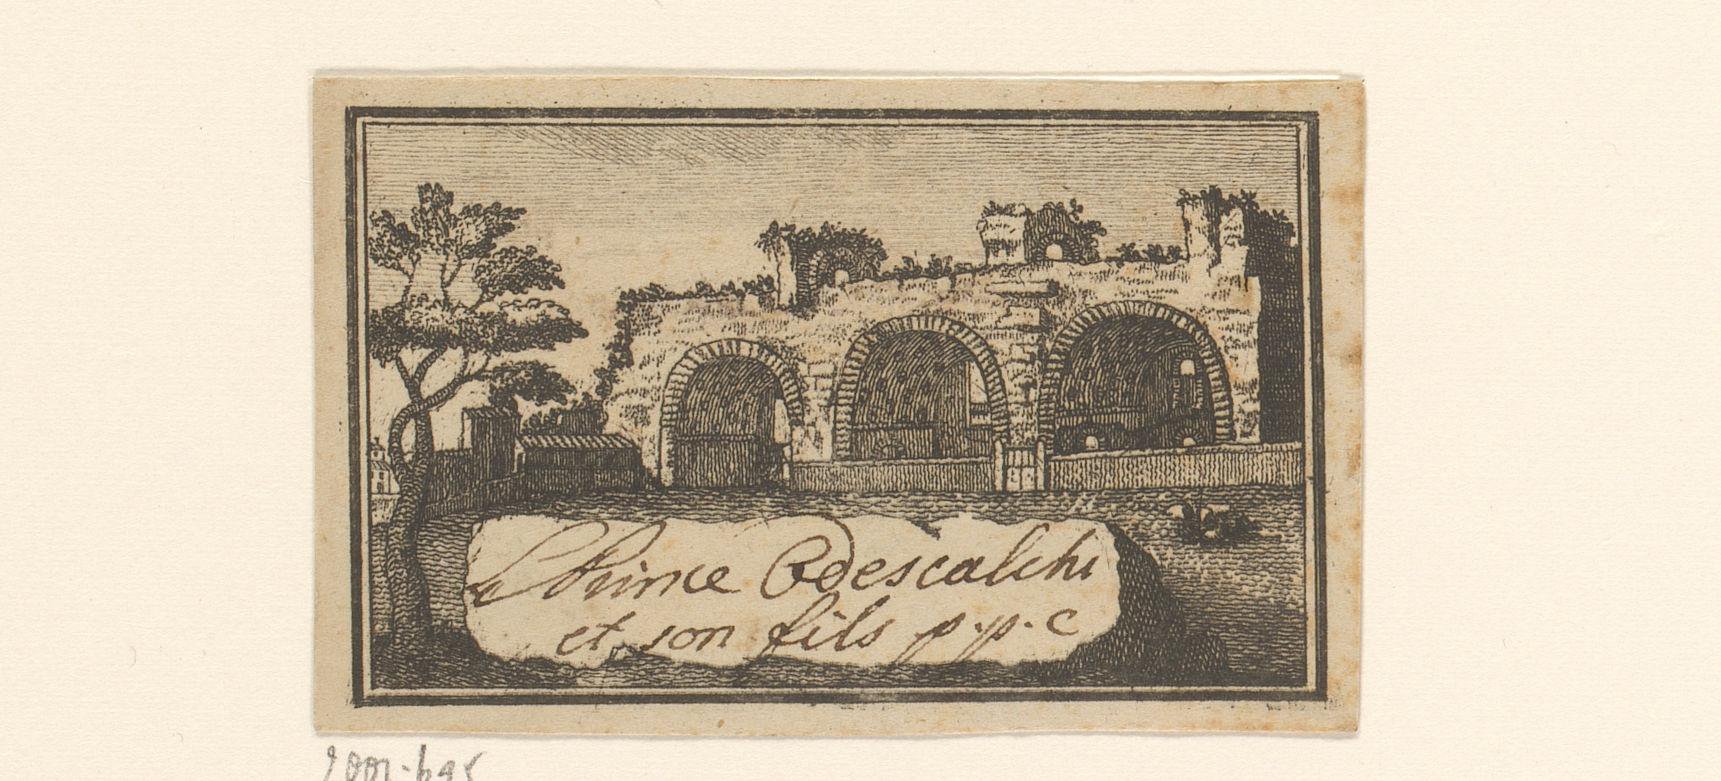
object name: visiting card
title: Visitekaart van 'Le Prince Odescalchi et son fils p.p.c.'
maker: Anonymous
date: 1700-1799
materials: paper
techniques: etching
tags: landscape with ruins, boulder, stone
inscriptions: collector's mark: Lugt 2228, collector's mark: Lugt 2760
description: Landschap met antieke ruïne en links een boom. Op de voorgrond een brede steen waarop in handschrift de naam geschreven is. Onduidelijk is om welk lid van de familie Odeschalchi het hier gaat.